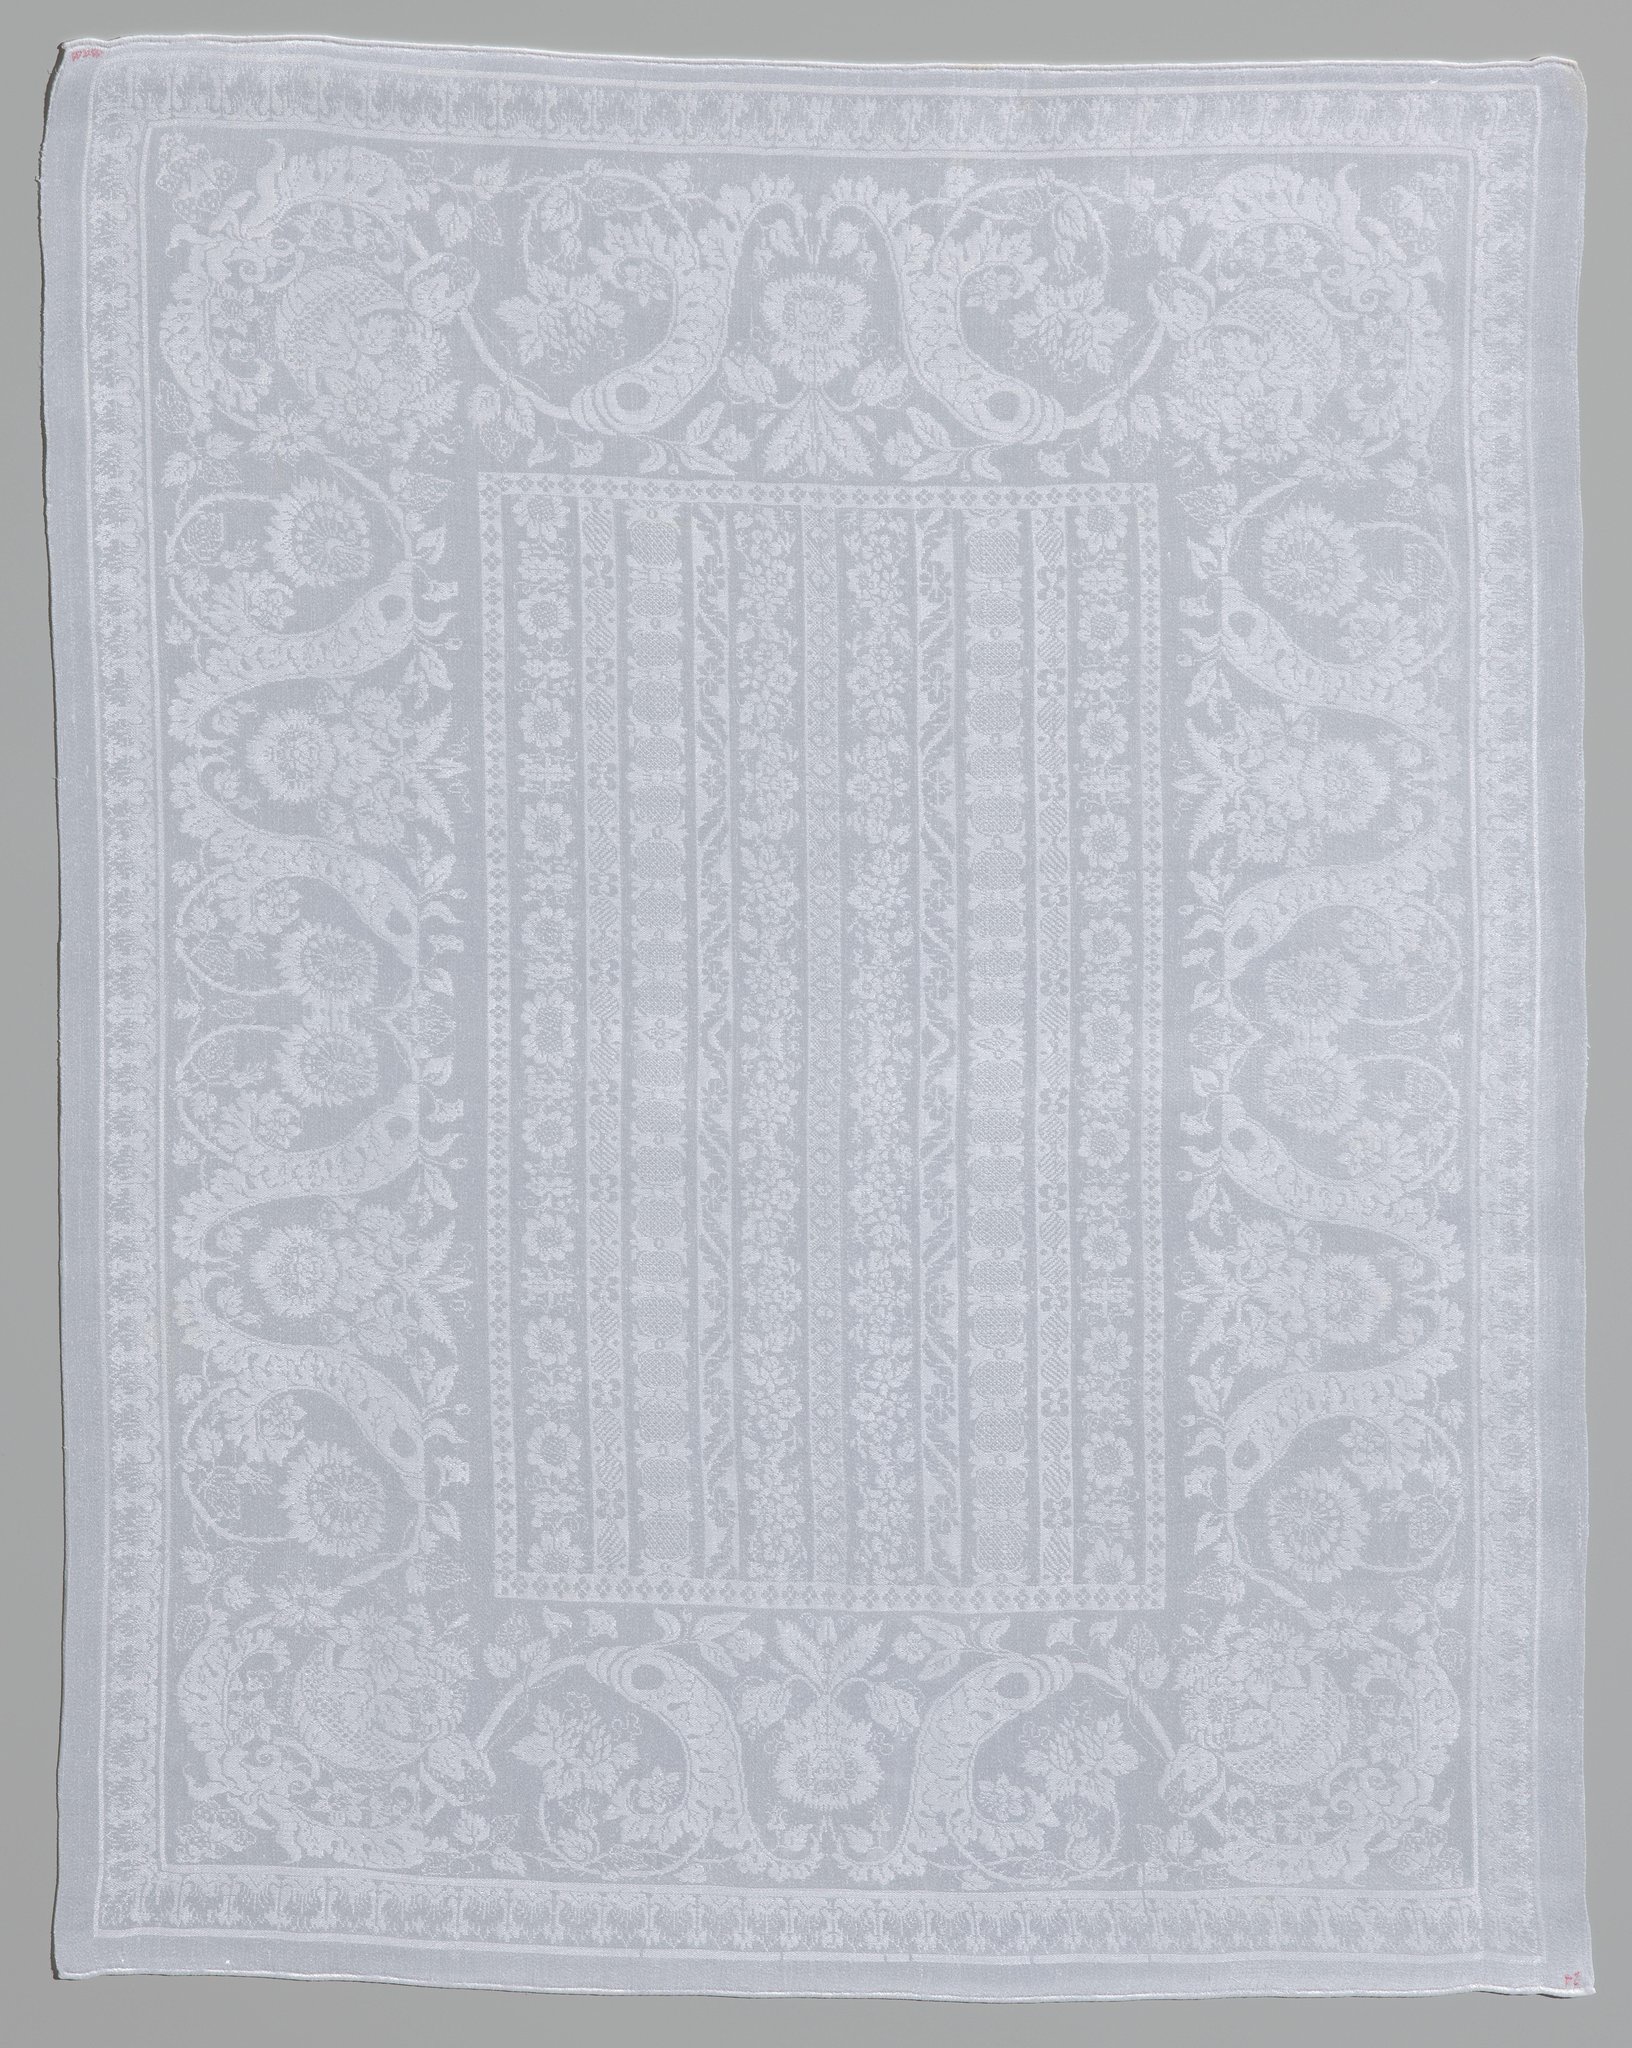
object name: napkin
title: Servet van damast met geornamenteerde lengtestrepen binnen rand met voluten, bloemen en een bloemenmand.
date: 1840-1860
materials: linen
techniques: damask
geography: netherlands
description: Wit linnen damasten servet met geornamenteerde lengtestrepen binnen een rand met voluten, bloemen en een bloemenmand. Gemerkt: WdW en 24.